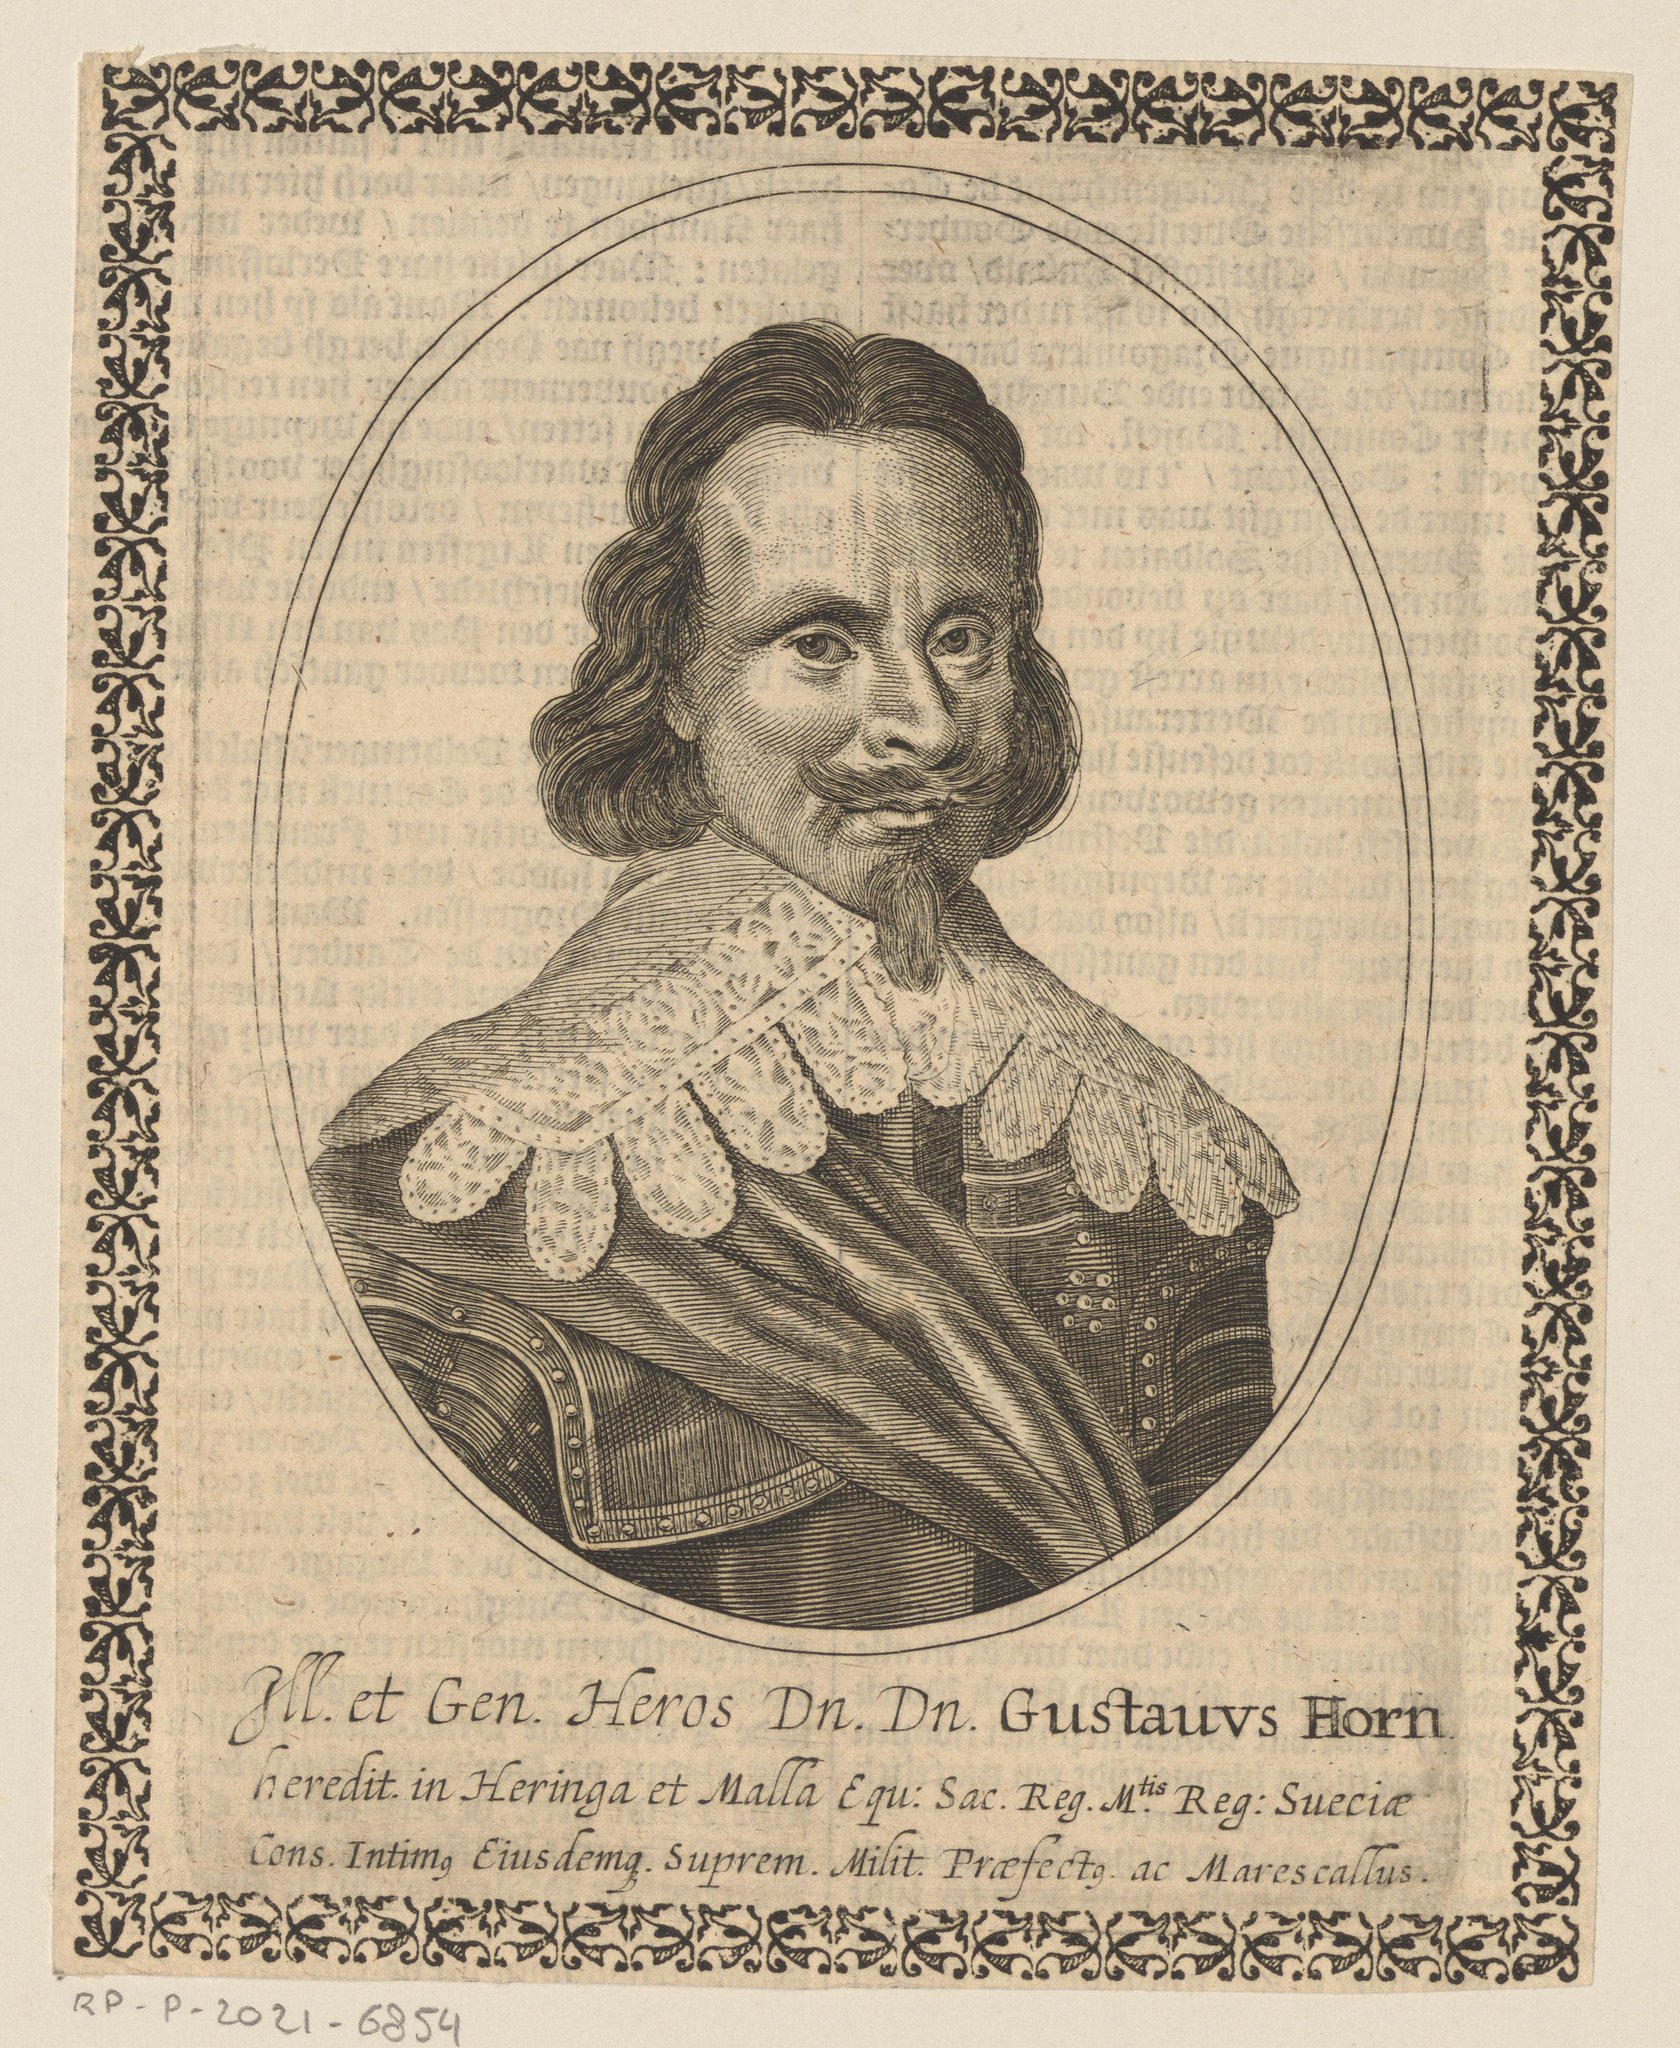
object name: book illustration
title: Portret van Gustav Horn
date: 1642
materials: paper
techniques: engraving, letterpress printing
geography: amsterdam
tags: commander-in-chief, general, marshal, historical persons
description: Prent uit: Abelin, Johann Philipp. Historis oft waerachtich verhael van den gantschen toestant van oorlooge, soo die ghevoert is in Duytschlandt (...). Amsterdam: Cornelis Danckerts, 1642, p. 166.